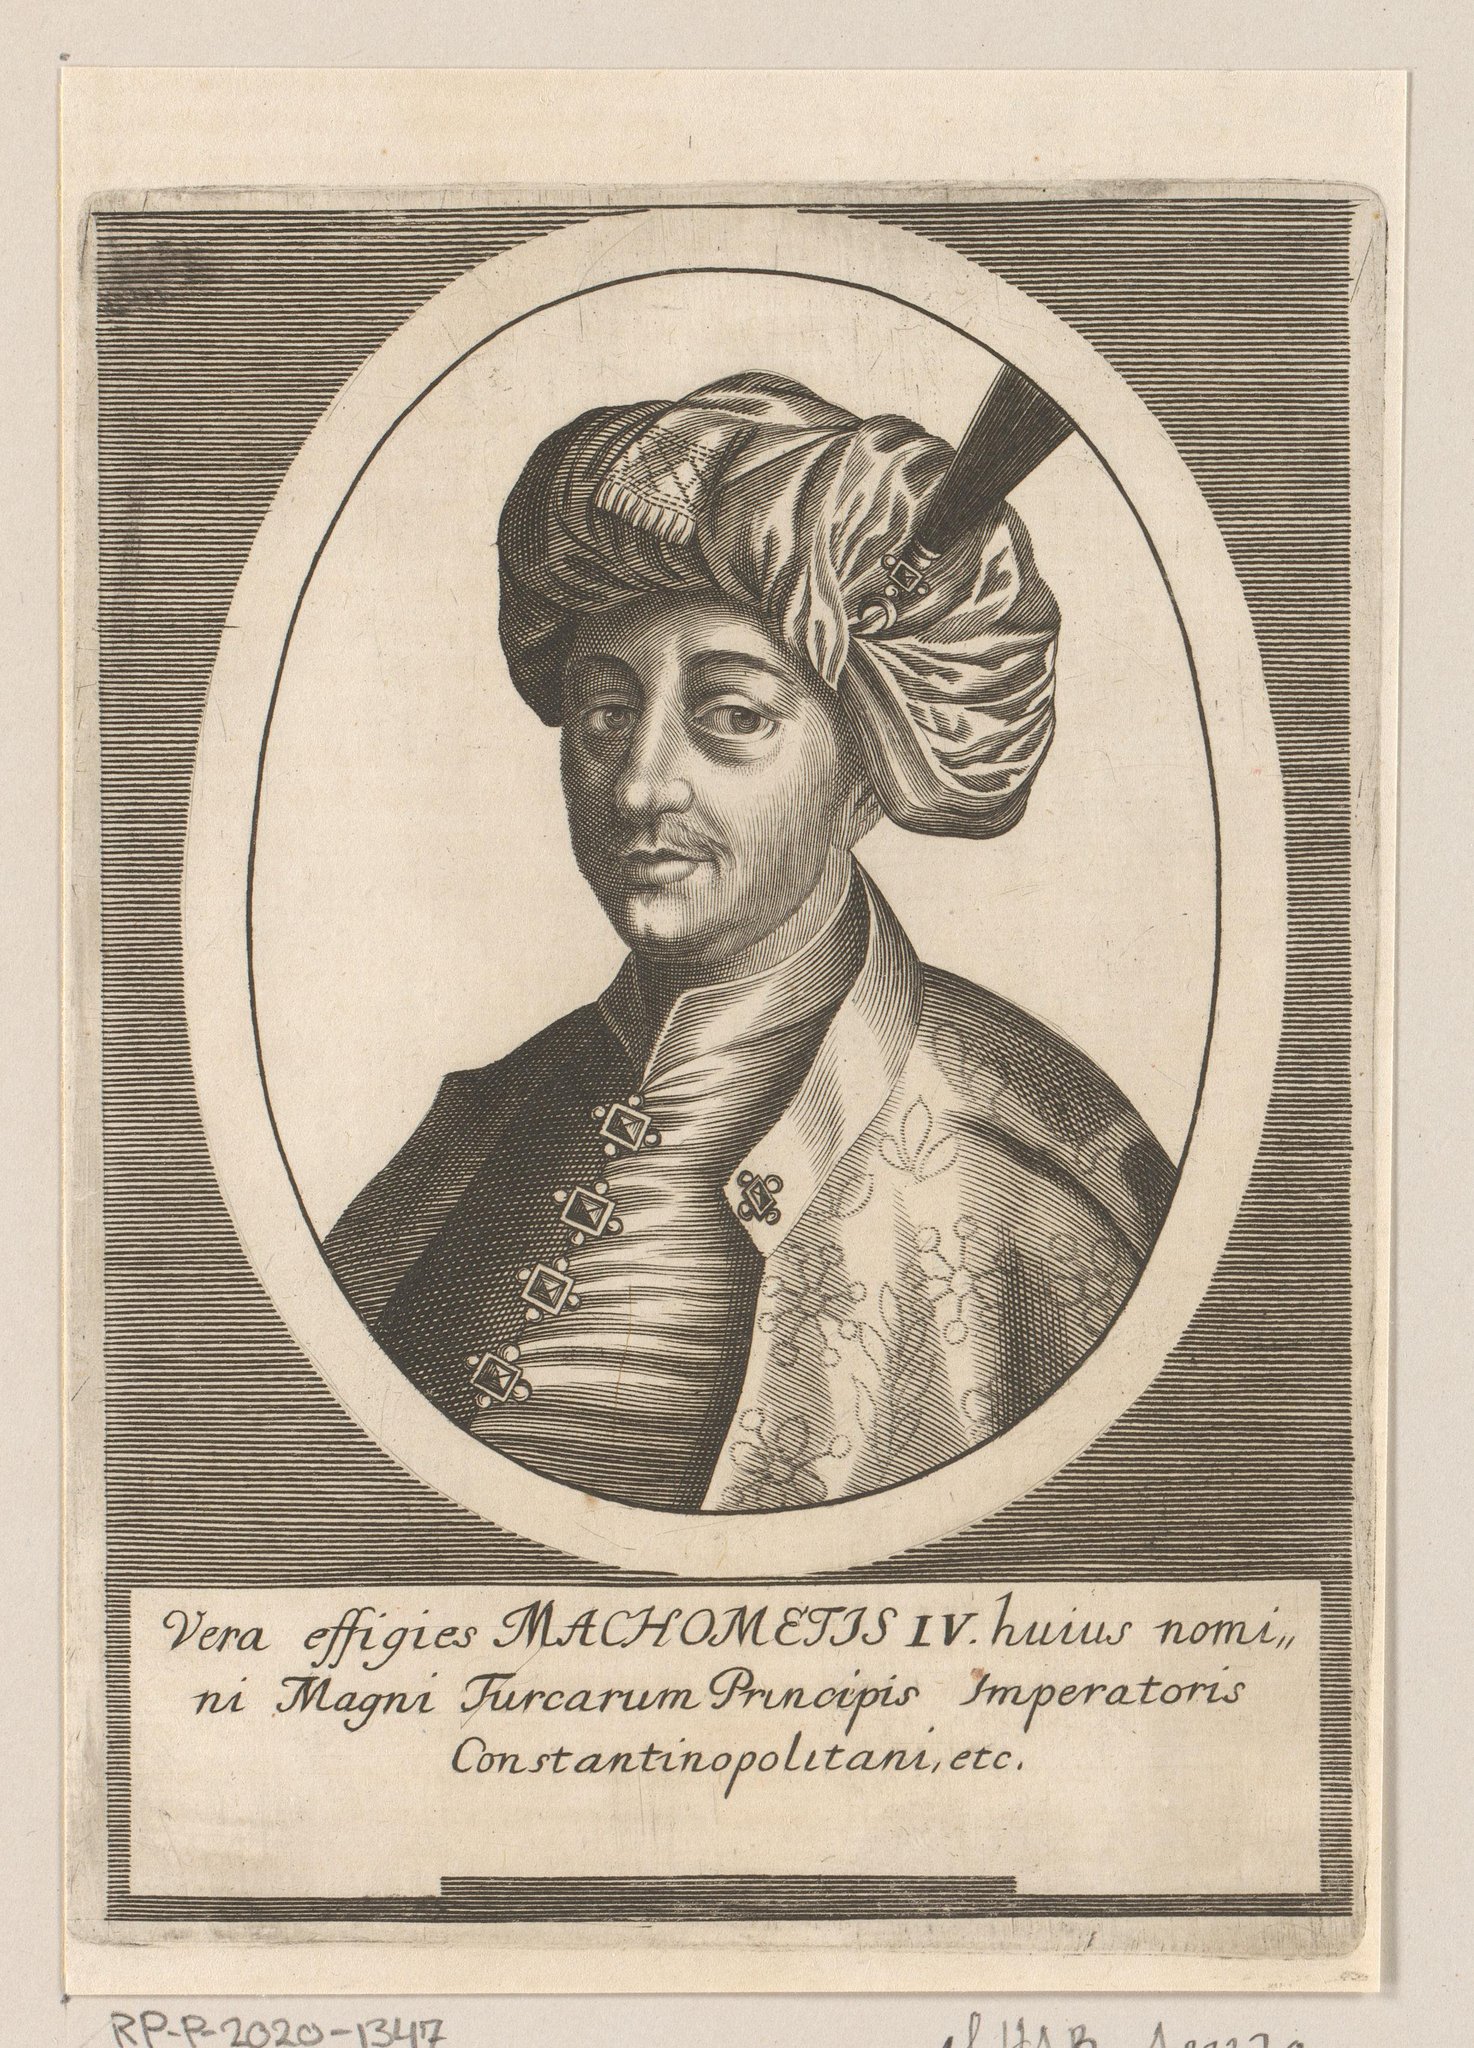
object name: print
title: Portret van Mehmet IV, sultan van het Ottomaanse Rijk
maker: Anonymous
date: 1691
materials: paper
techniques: engraving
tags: historical persons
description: Prent ook gebruikt in: Meyer, Martin. Theatrum Europaeum (...). Frankfurt am Main: erven Matthäus Merian I, Johann Phillip Abelinus en Heinrich Oraeus, 1691.